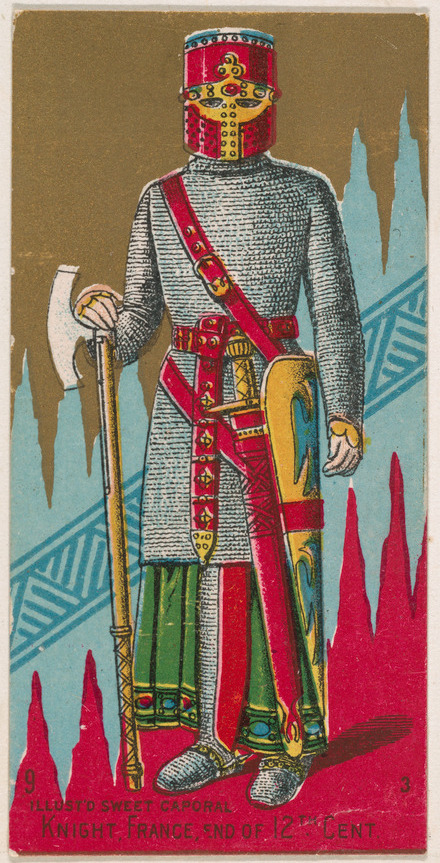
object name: print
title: Knight, France, End of 12th Century, from the Military Series (N224) issued by Kinney Tobacco Company to promote Sweet Caporal Cigarettes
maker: kinney brothers tobacco company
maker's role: publisher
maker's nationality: american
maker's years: 1869-2011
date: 1888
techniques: color lithograph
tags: men,knights